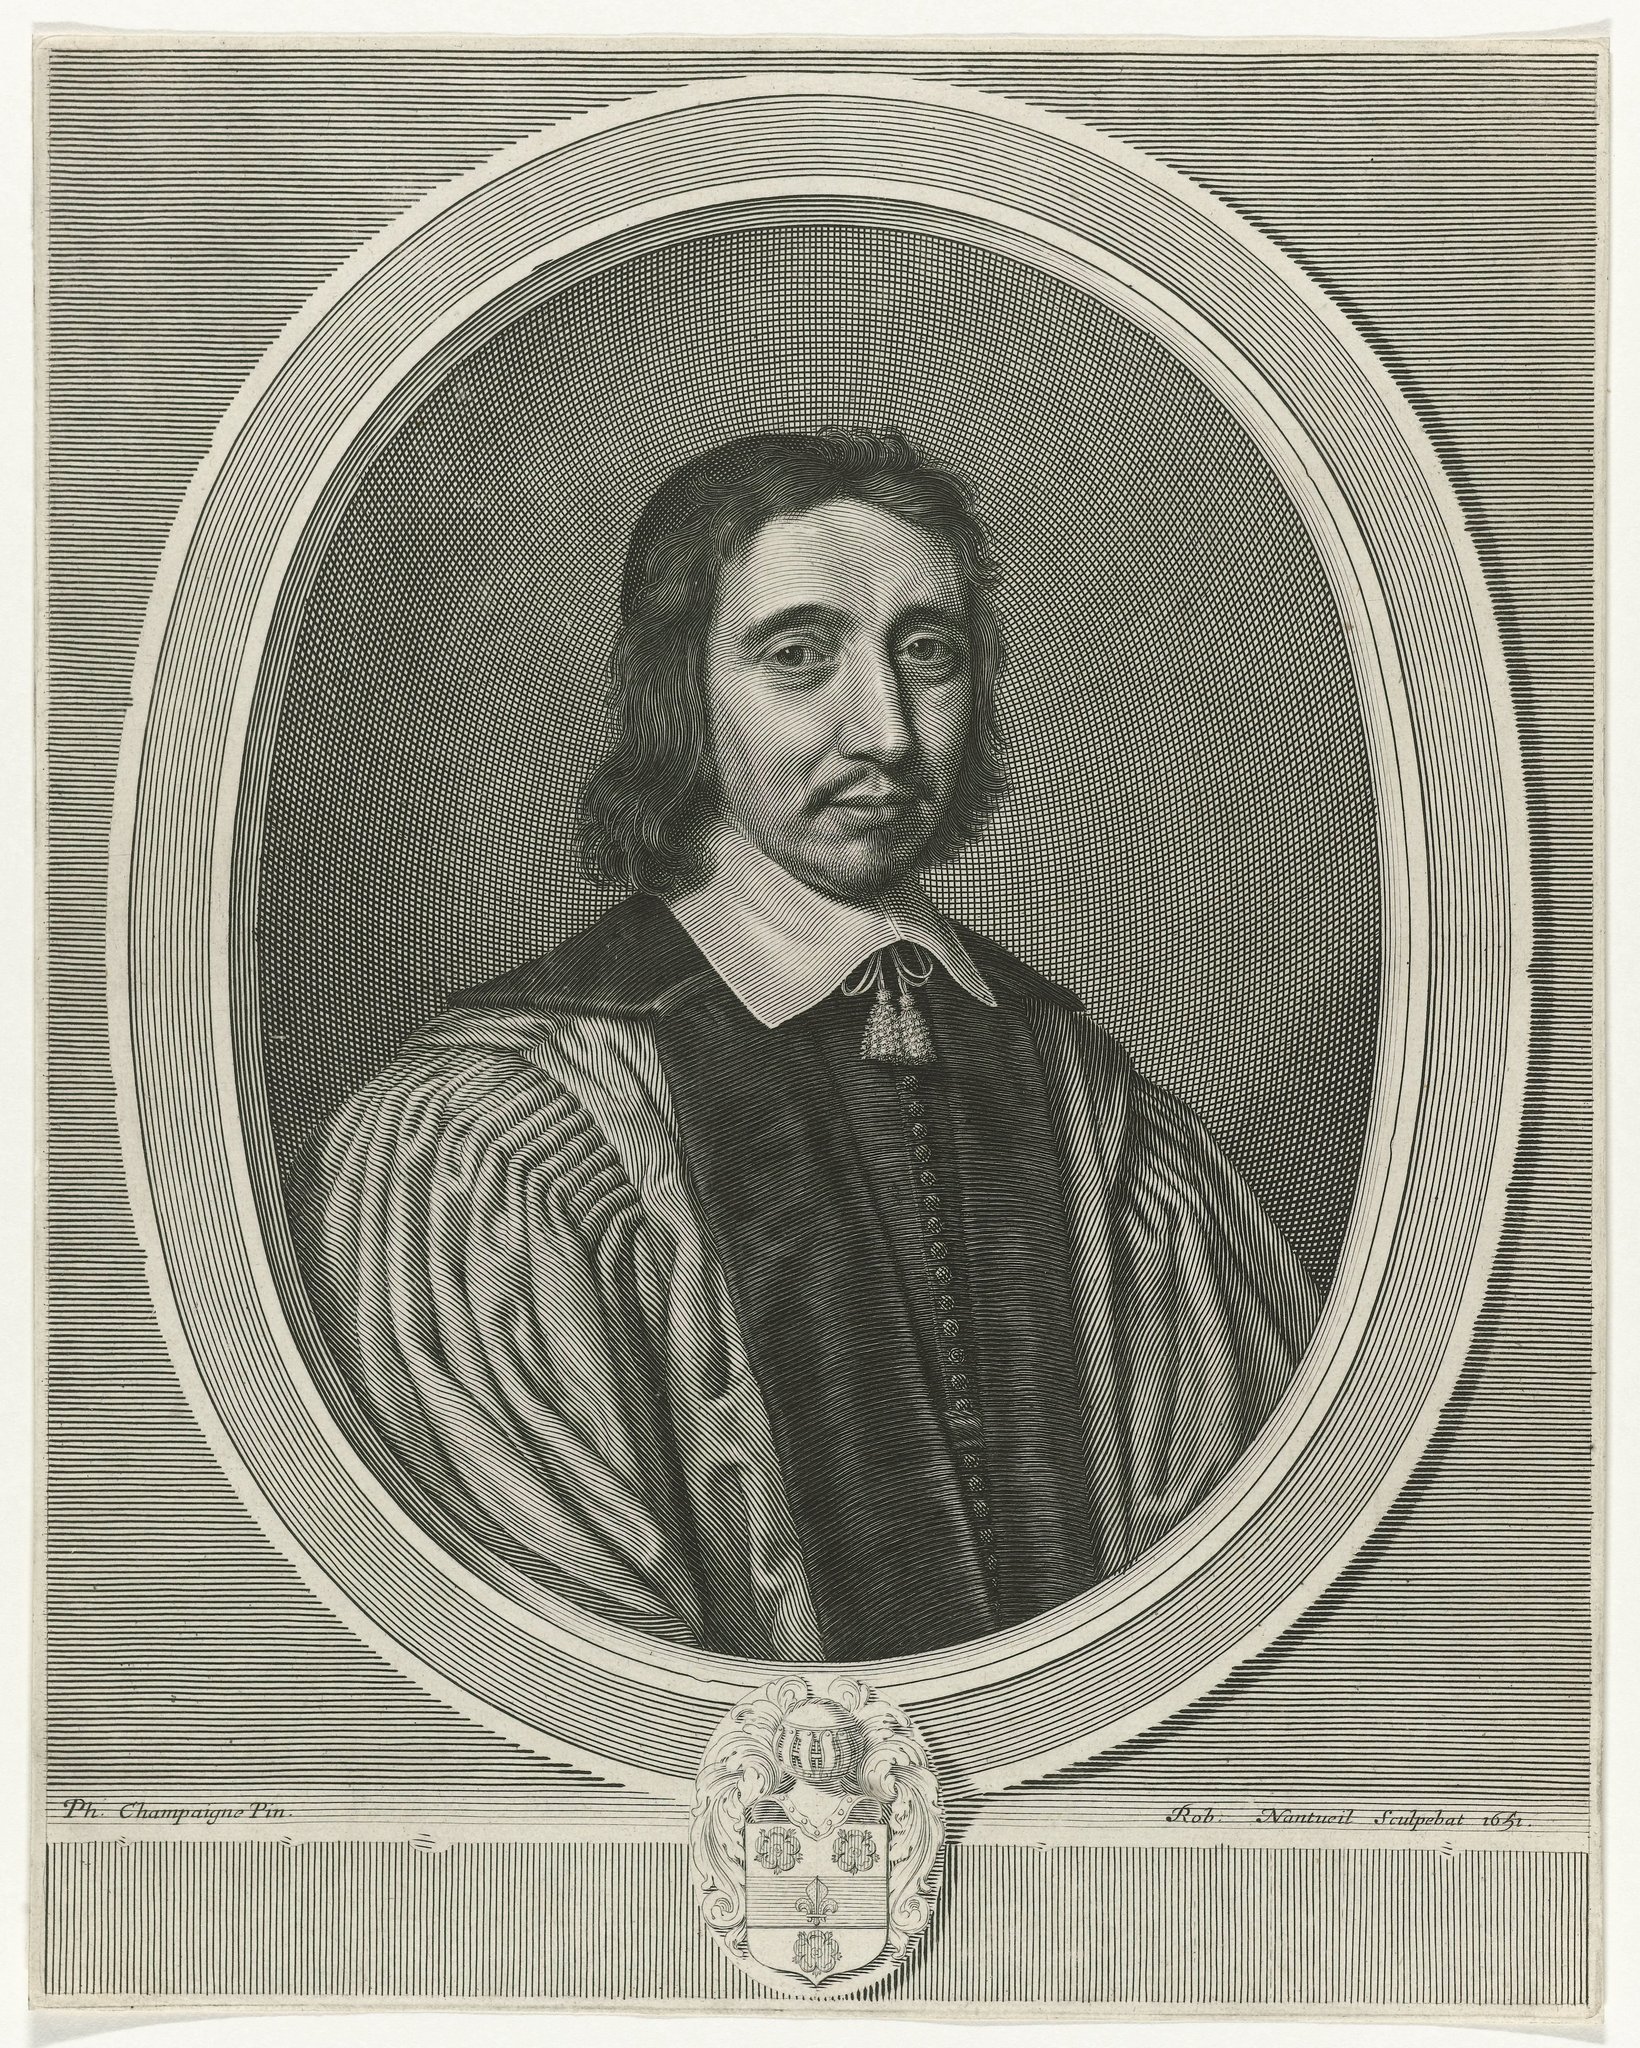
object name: print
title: Portret Charles Benoise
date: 1651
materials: paper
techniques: engraving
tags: charles benoise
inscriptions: date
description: Buste naar rechts, in ovale lijst. Wapen middenonder.